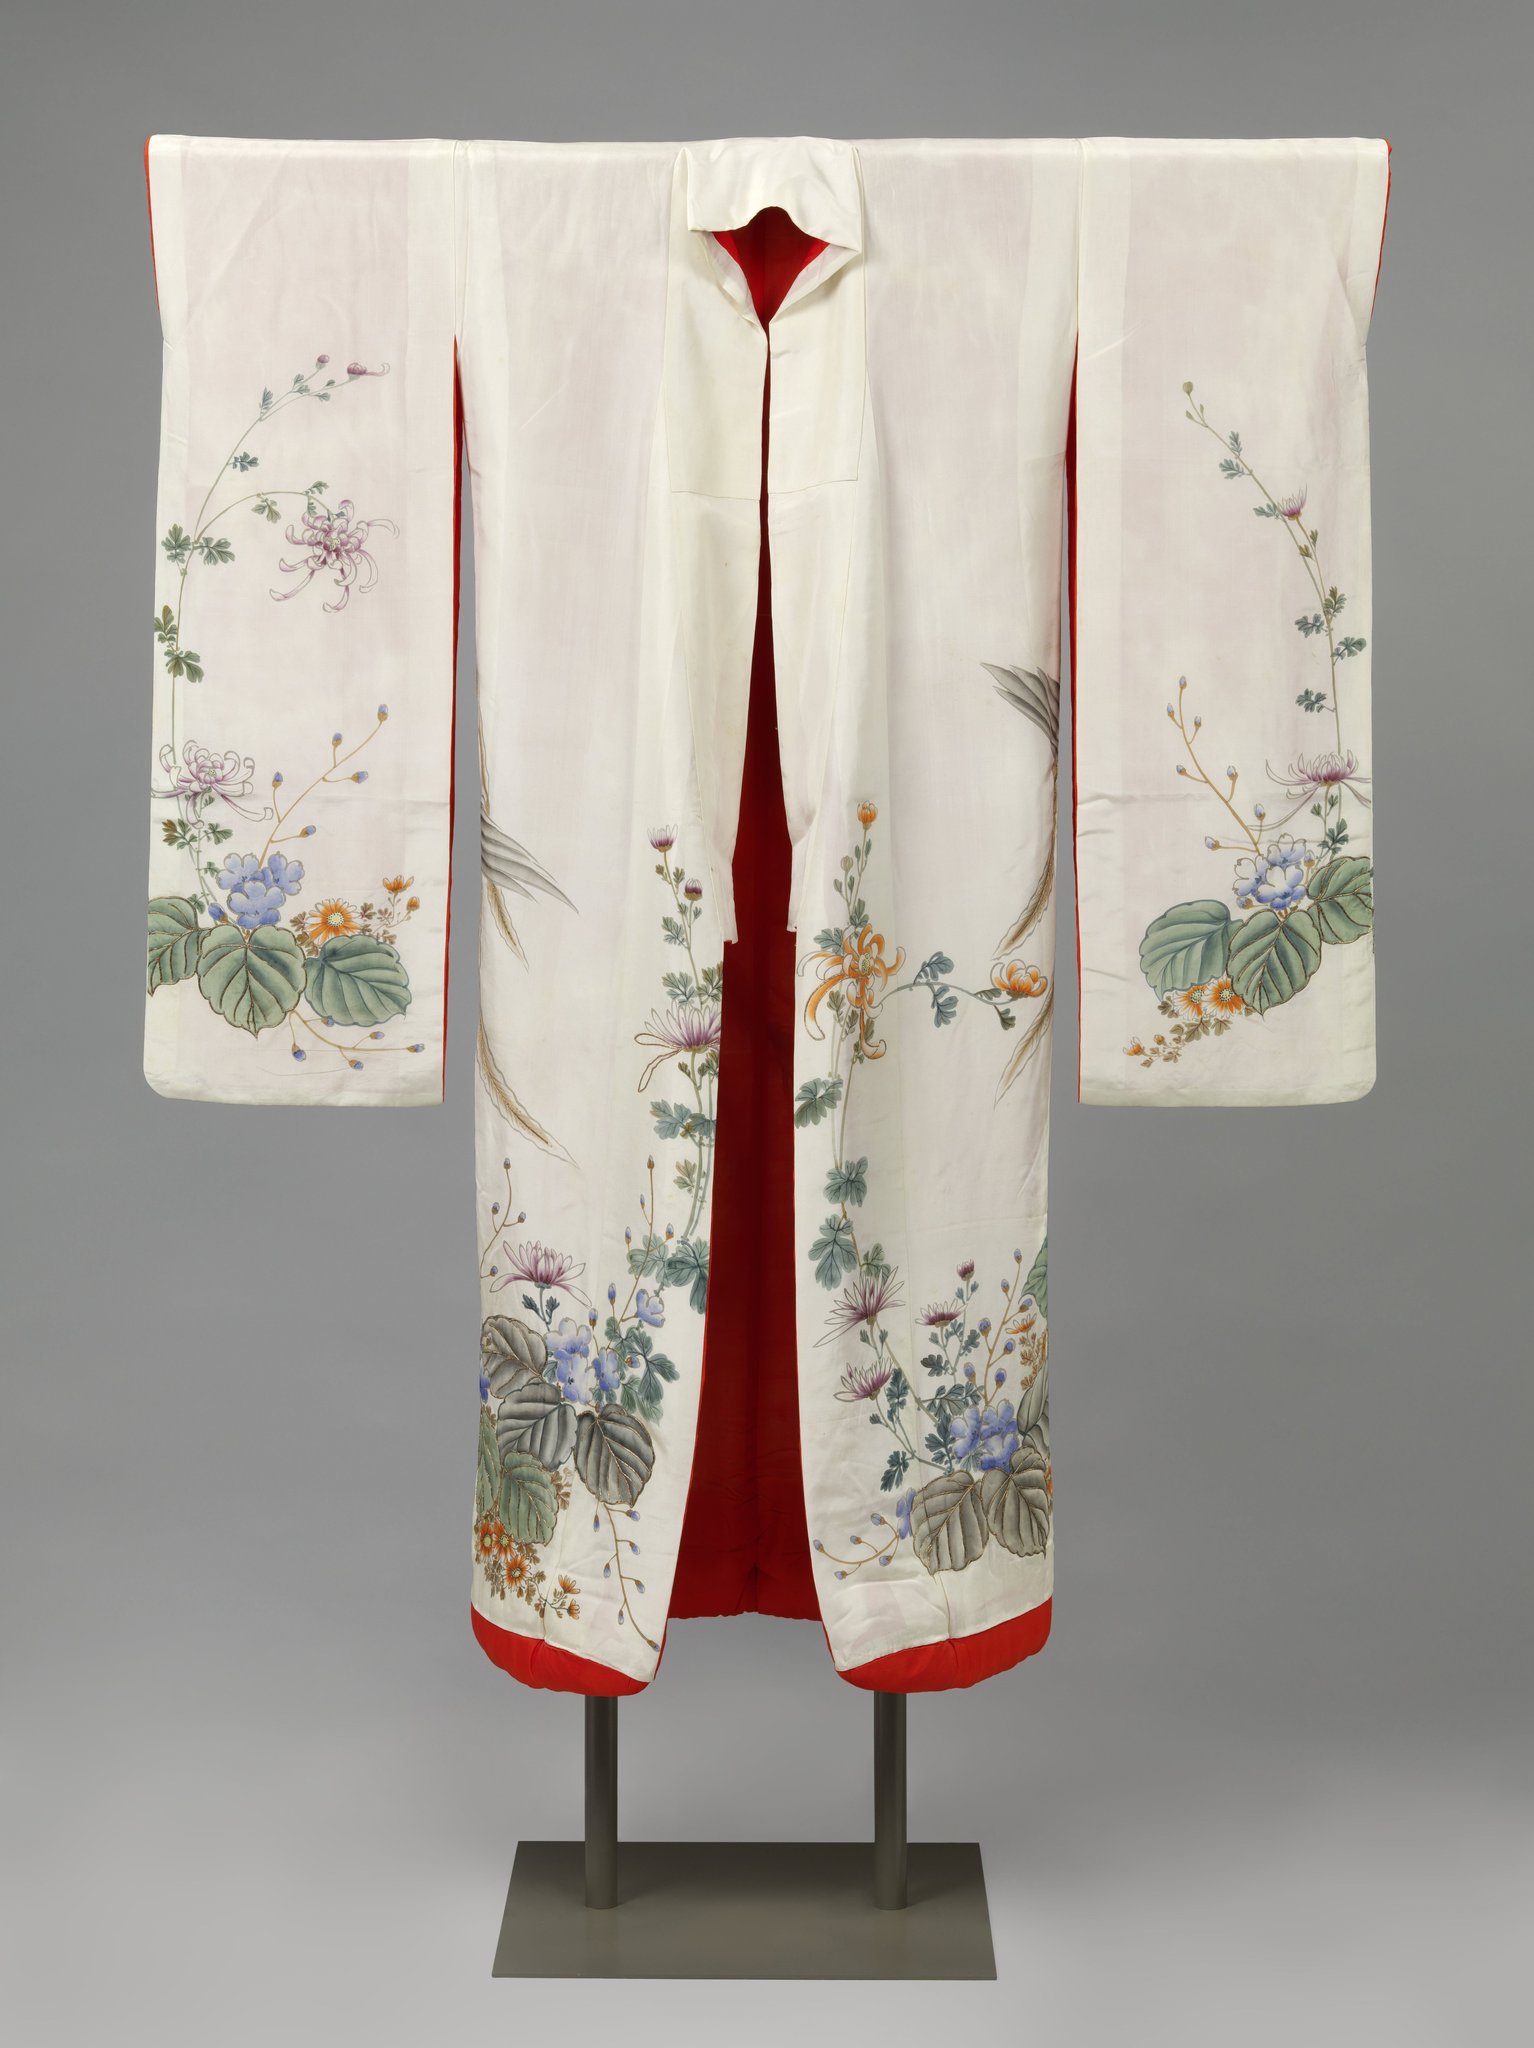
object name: kimono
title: Uchikake met feniks, paulownia en chrysanten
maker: Anonymous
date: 1920-1940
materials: silk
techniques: painting, weave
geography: japan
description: Gevoerde bruidskimono (uchikake), op de achterpanden versierd met een grote feniks (hoo), met beneden en op de mouwen bloeiende paulownia en chrysanten. Witte zijde met geschilderde yuzen decoratie in blauw, bruin, groen, rood en paars. Voering van rode zijde. Drie familiewapens (mon) van bamboeblad.